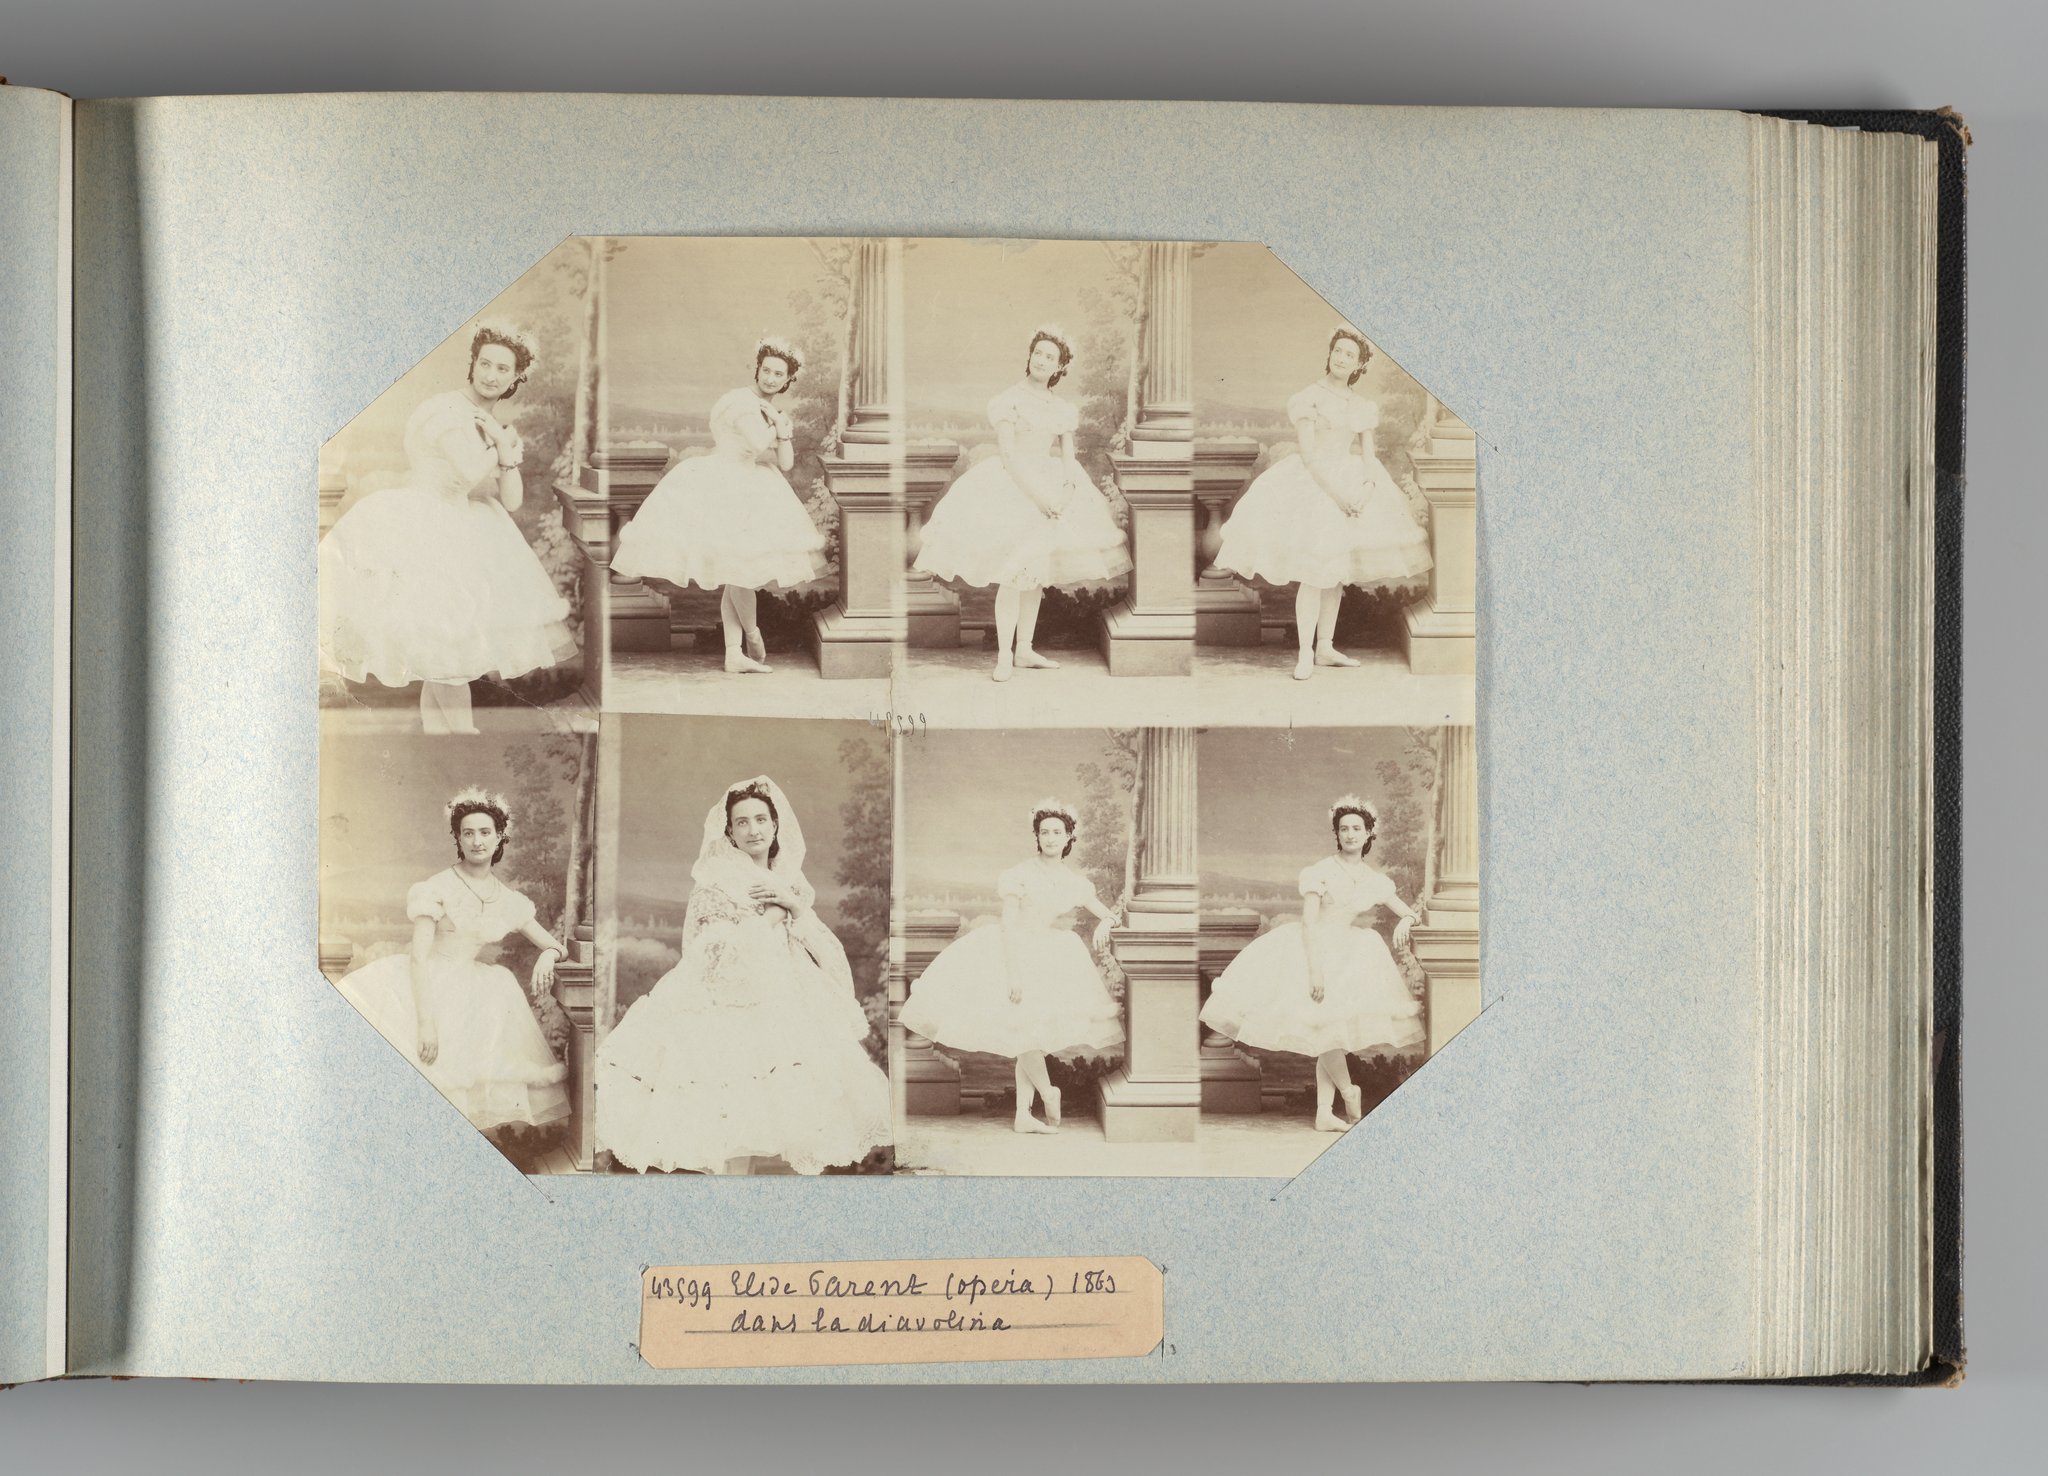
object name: photograph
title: Elise Parent dans la Diavolina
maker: andré-adolphe-eugène disdéri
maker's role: artist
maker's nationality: french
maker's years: 1819-1889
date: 1863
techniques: albumen silver print, glass negative